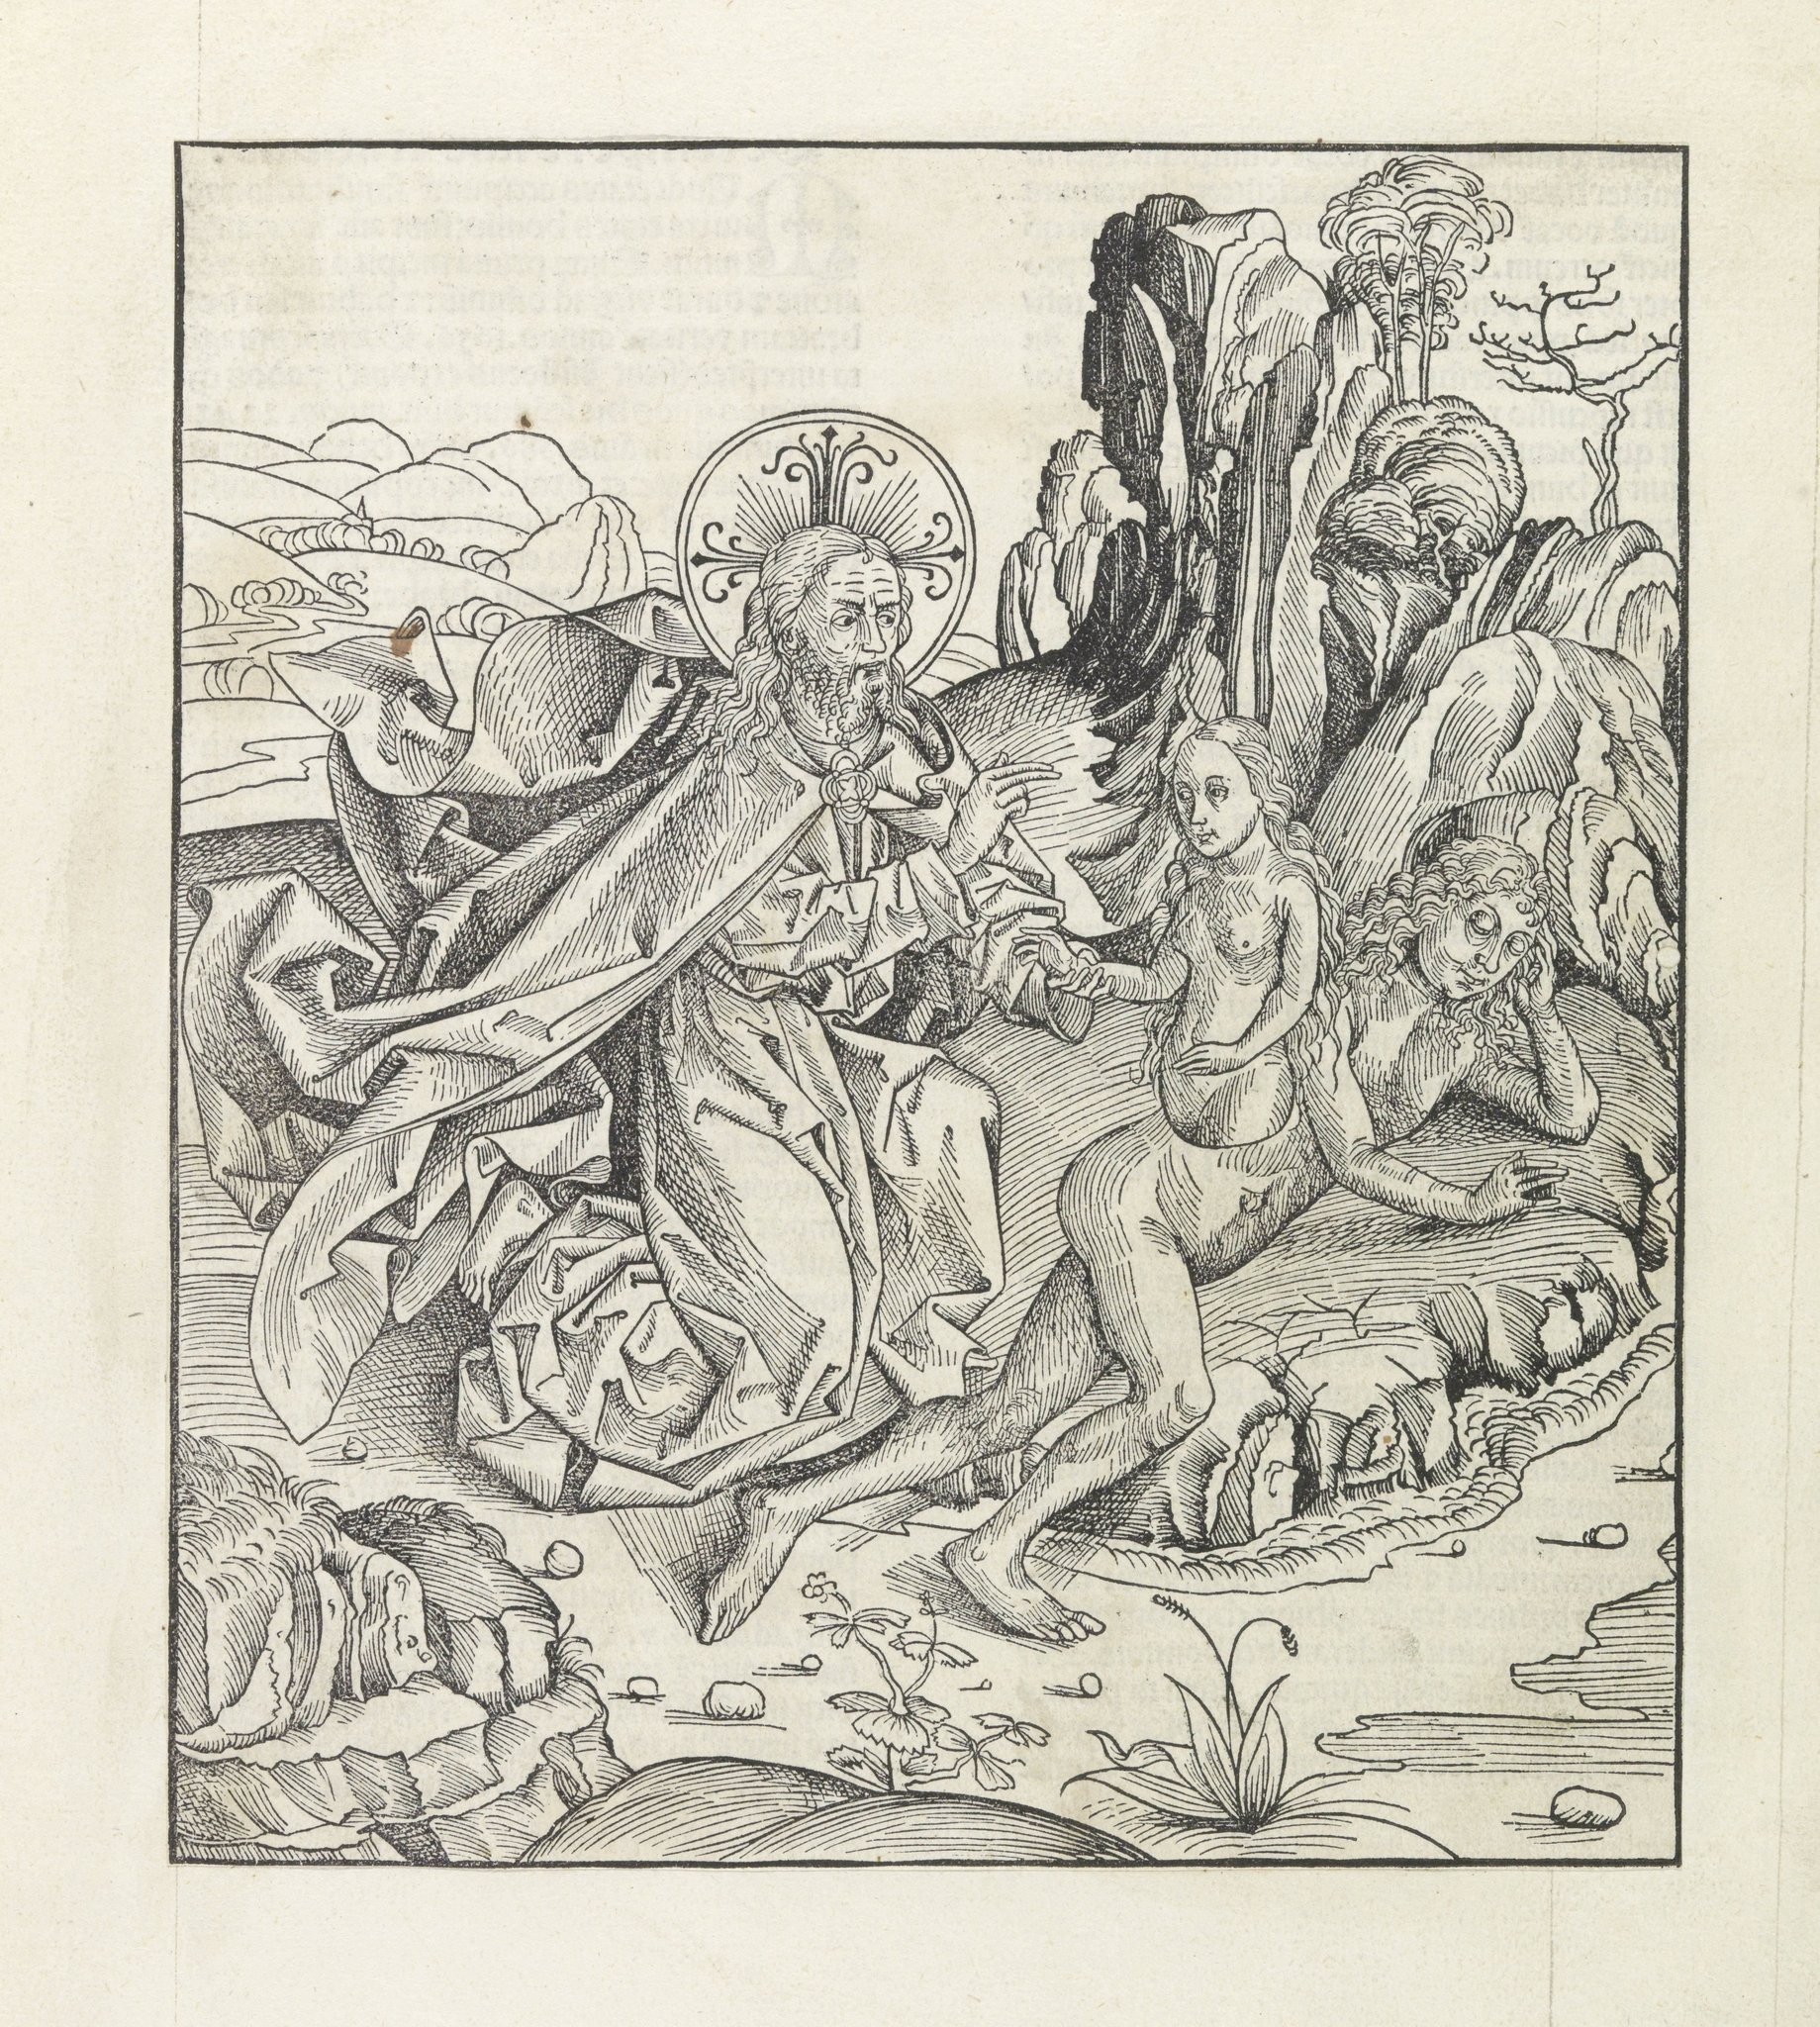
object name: album leaf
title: Schepping van Eva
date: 1493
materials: paper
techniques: letterpress printing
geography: nuremberg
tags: eve emerges from adam's body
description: De houtsnede wordt gebruikt als boekillustratie in de Liber Chronicarum (of Neurenbergkroniek) van Hartmann Schedel, verschenen in het Latijn en Duits in 1493. Zie folio 6v.